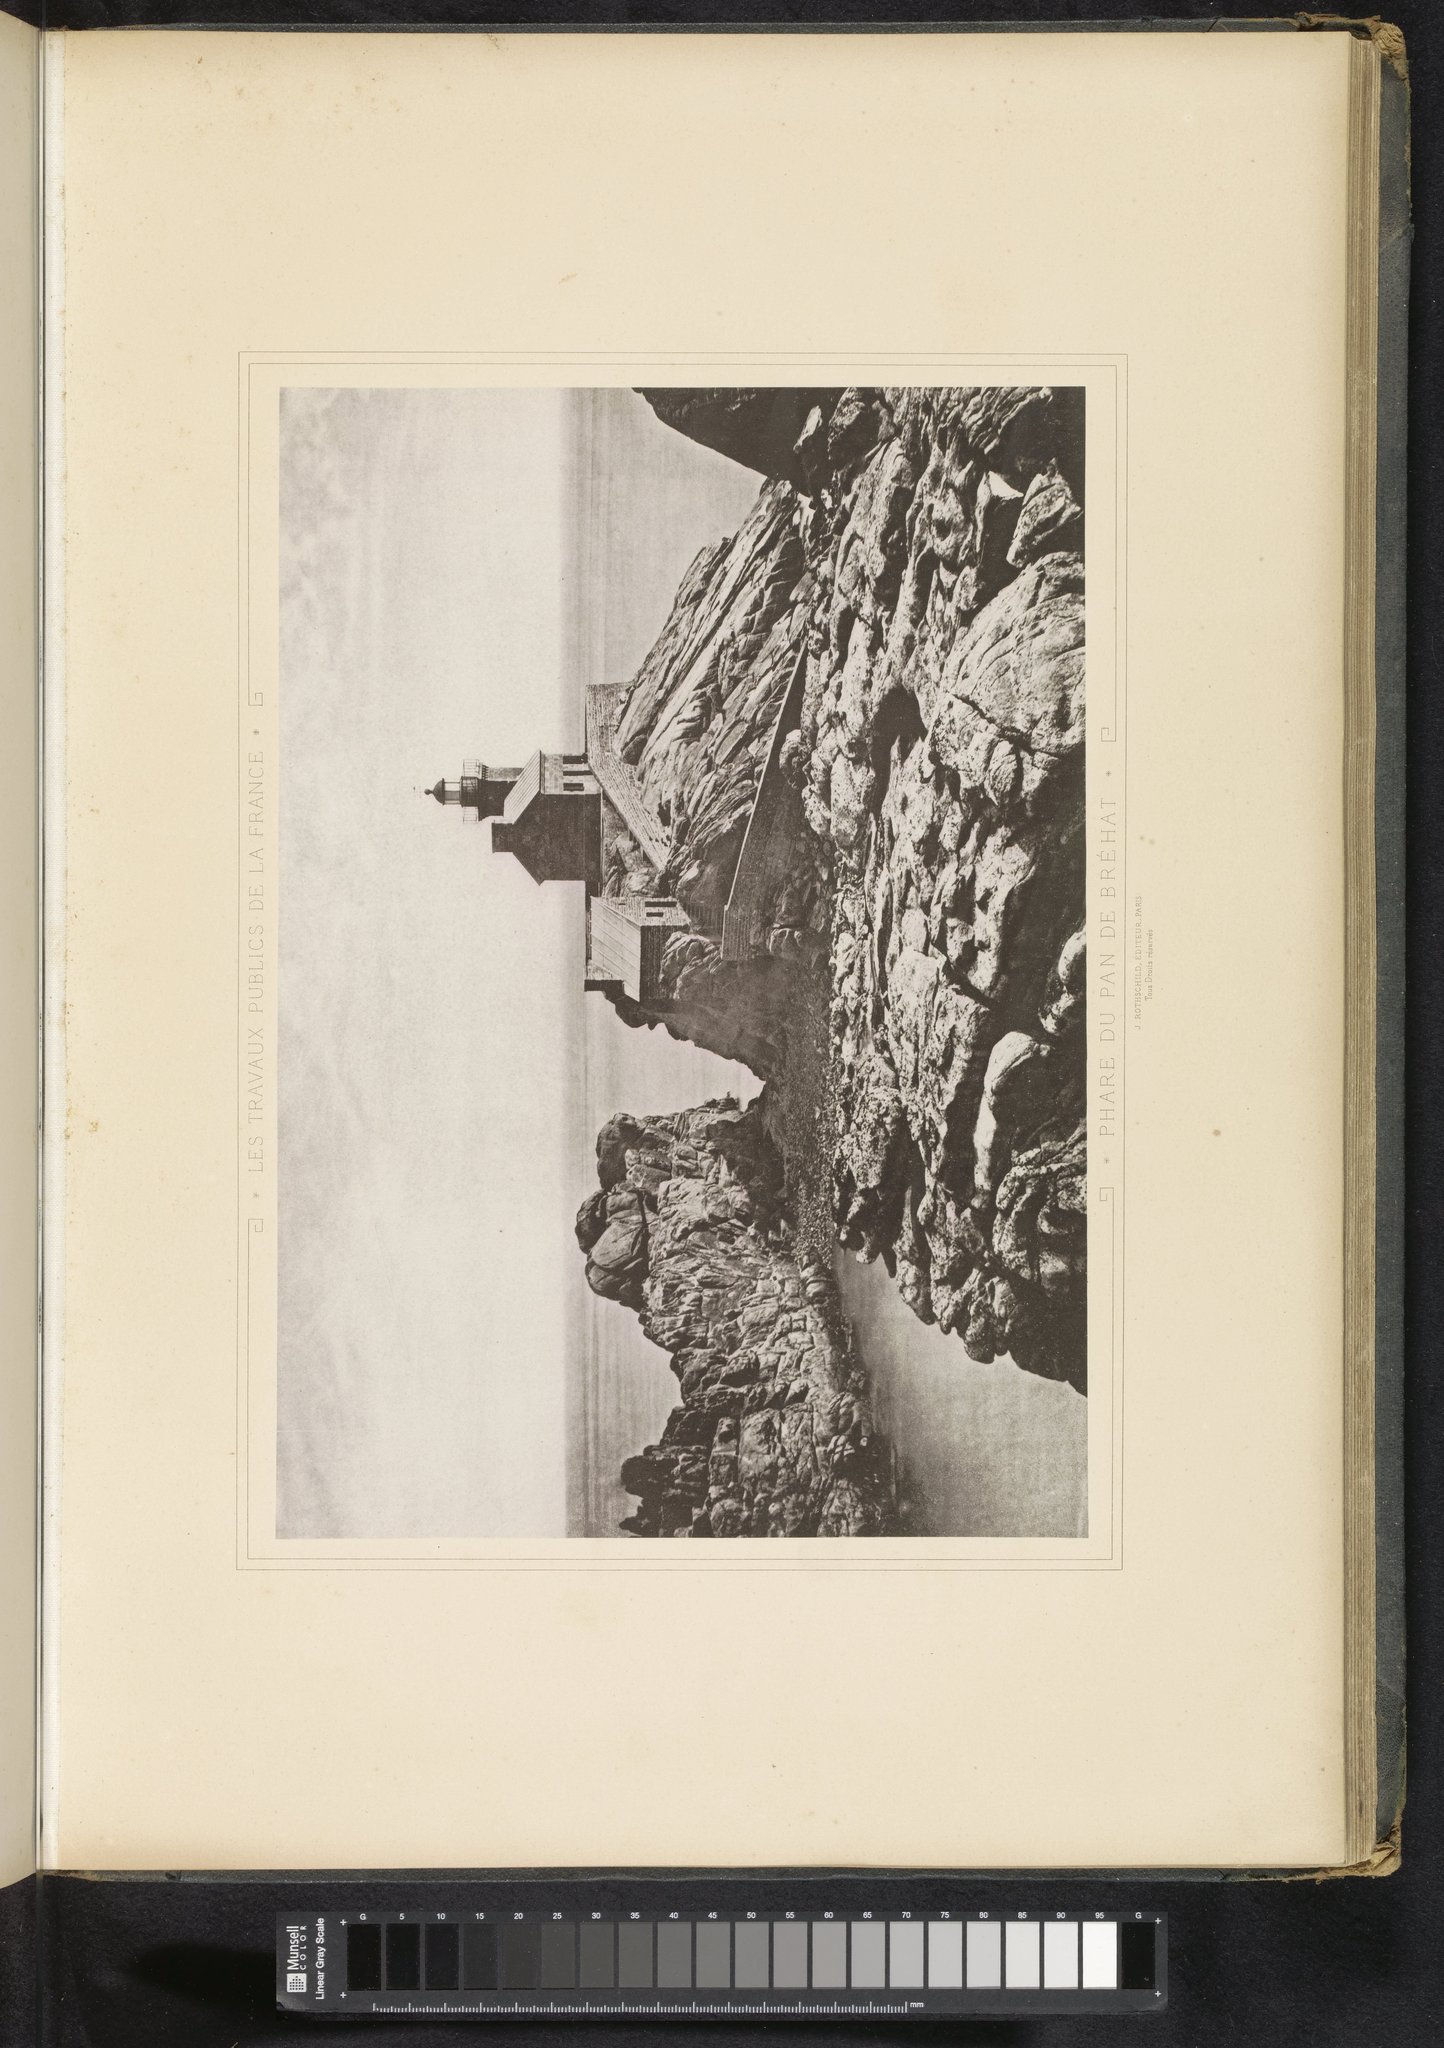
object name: photomechanical print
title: Vuurtoren van Pan de Bréhat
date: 1873-1883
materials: paper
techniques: photograph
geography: paris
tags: lighthouse, lightship, rocky coast